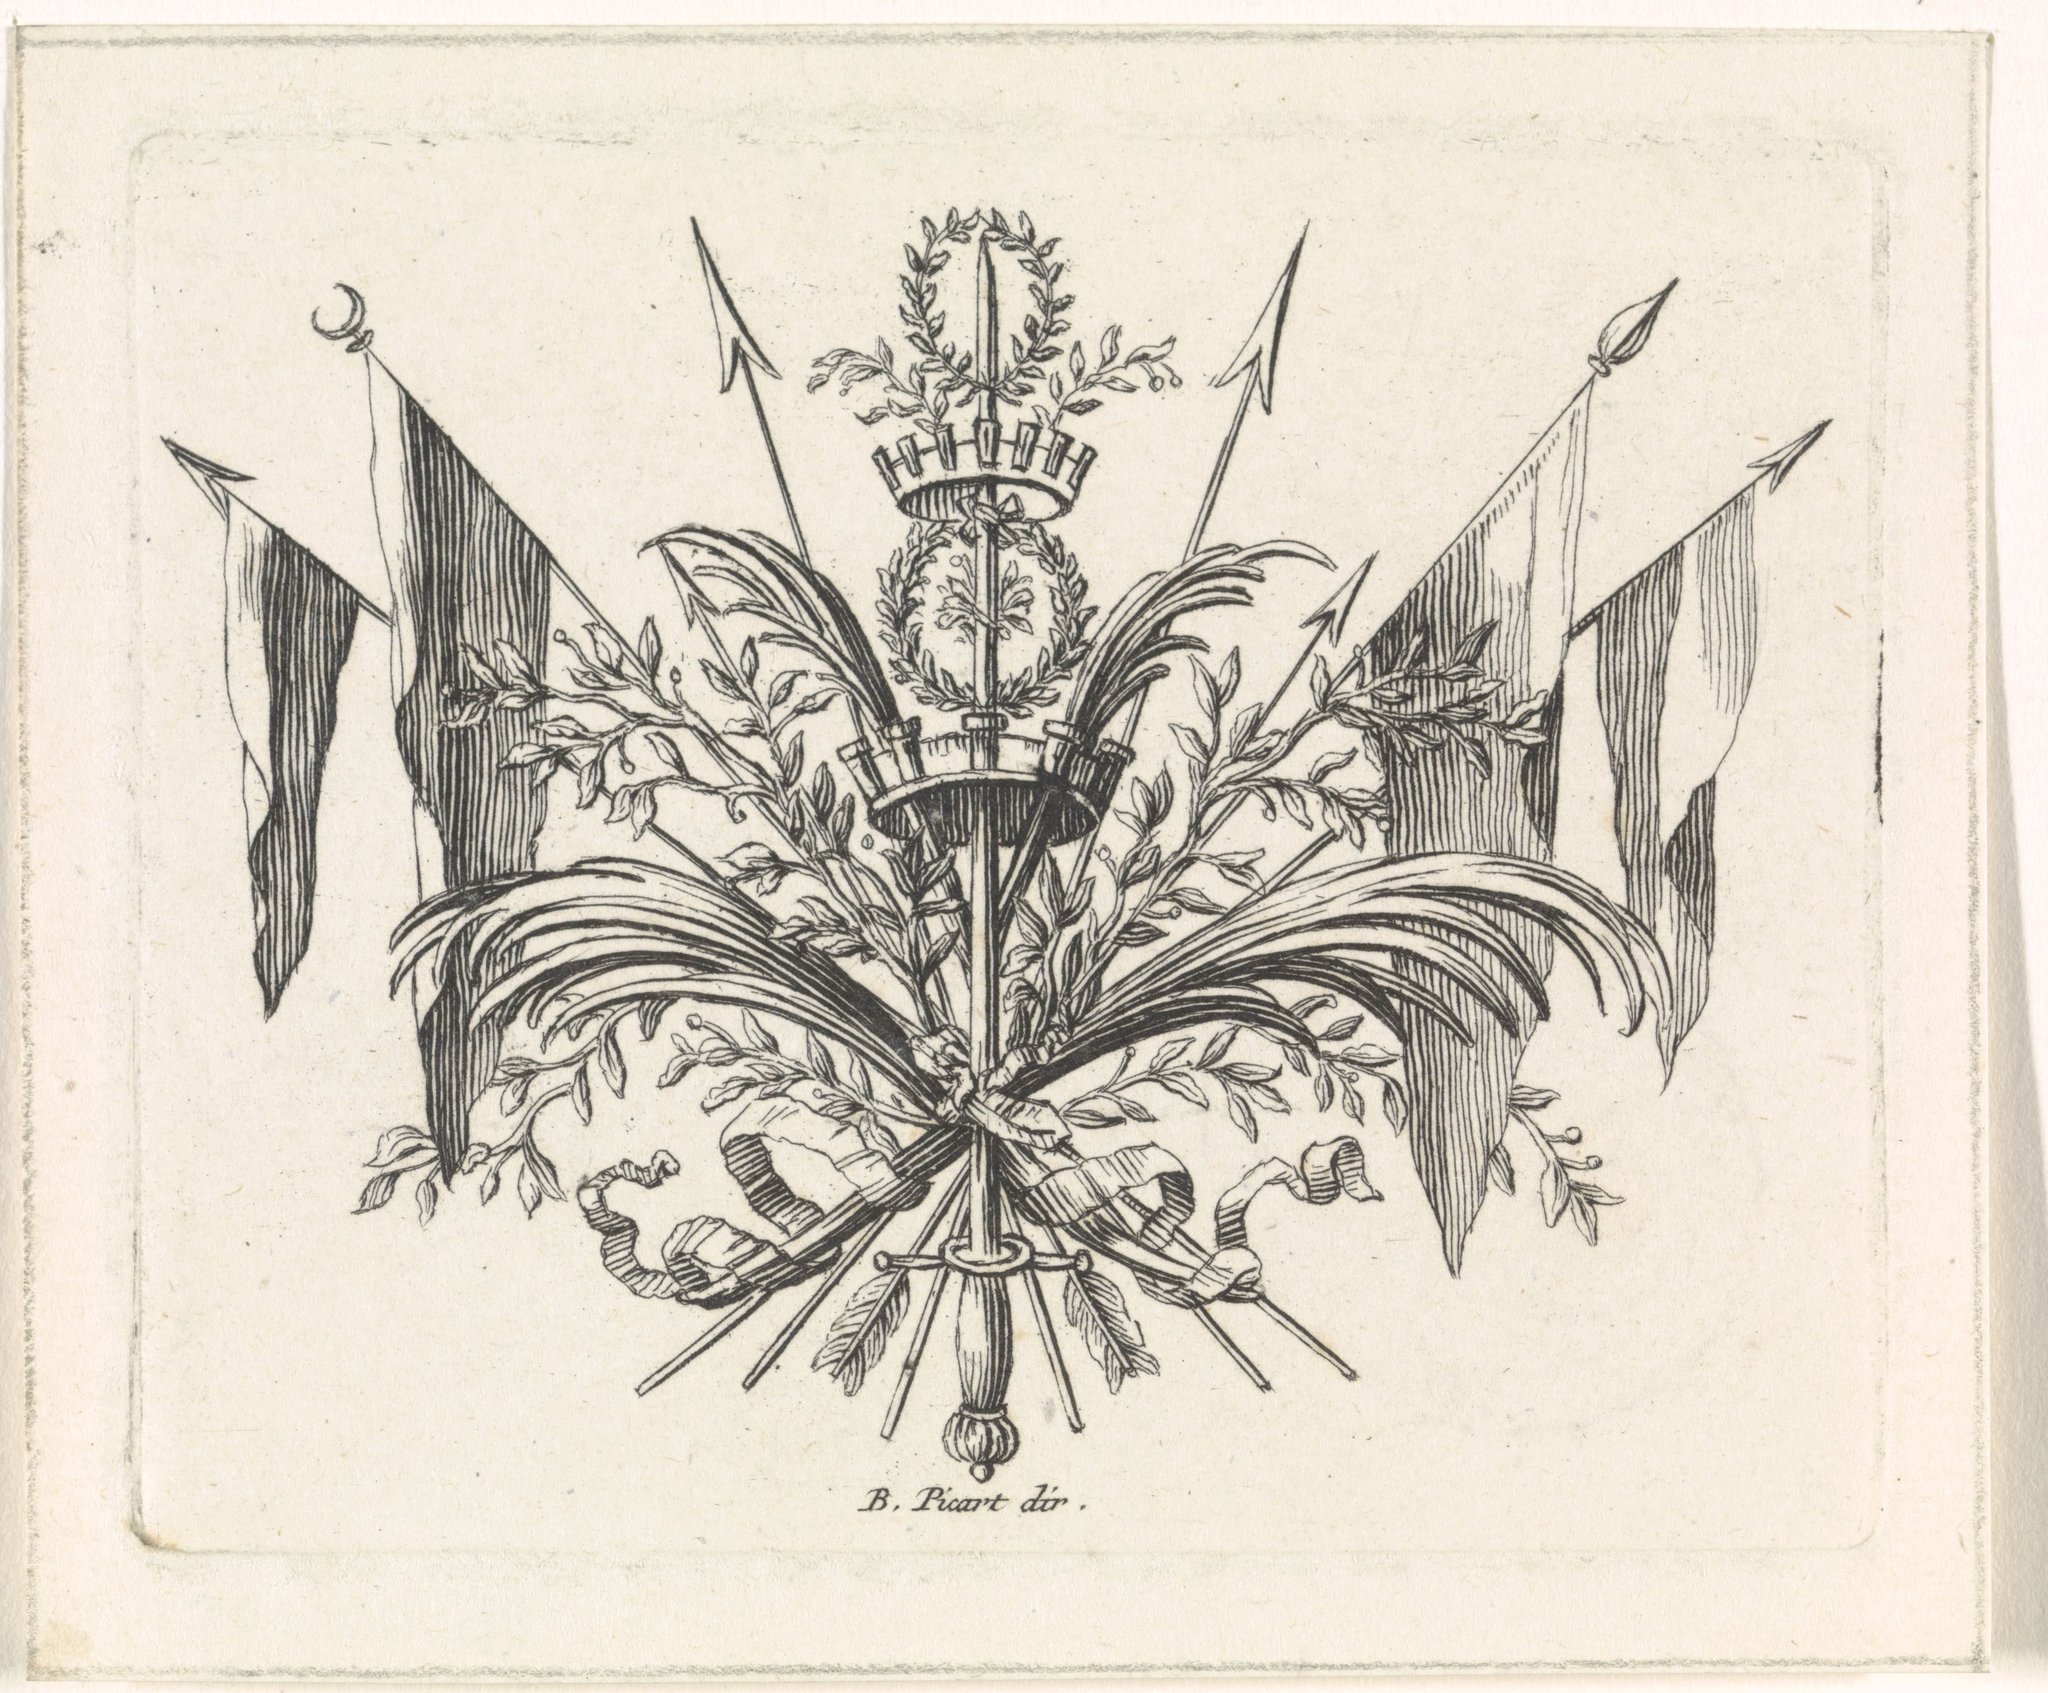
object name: print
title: Zwaard met kroon en lauwerkrans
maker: bernard picart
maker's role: draughtsman, print maker, publisher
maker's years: 1673-1733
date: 1683-1733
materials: paper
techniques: engraving, etching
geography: amsterdam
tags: trophy, i.e.: decorative arrangement of symbolic or typical objects ~ ornament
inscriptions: collector's mark: Lugt 240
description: Een zwaard met kroon, gebundeld met palmtakken, speren en banieren.